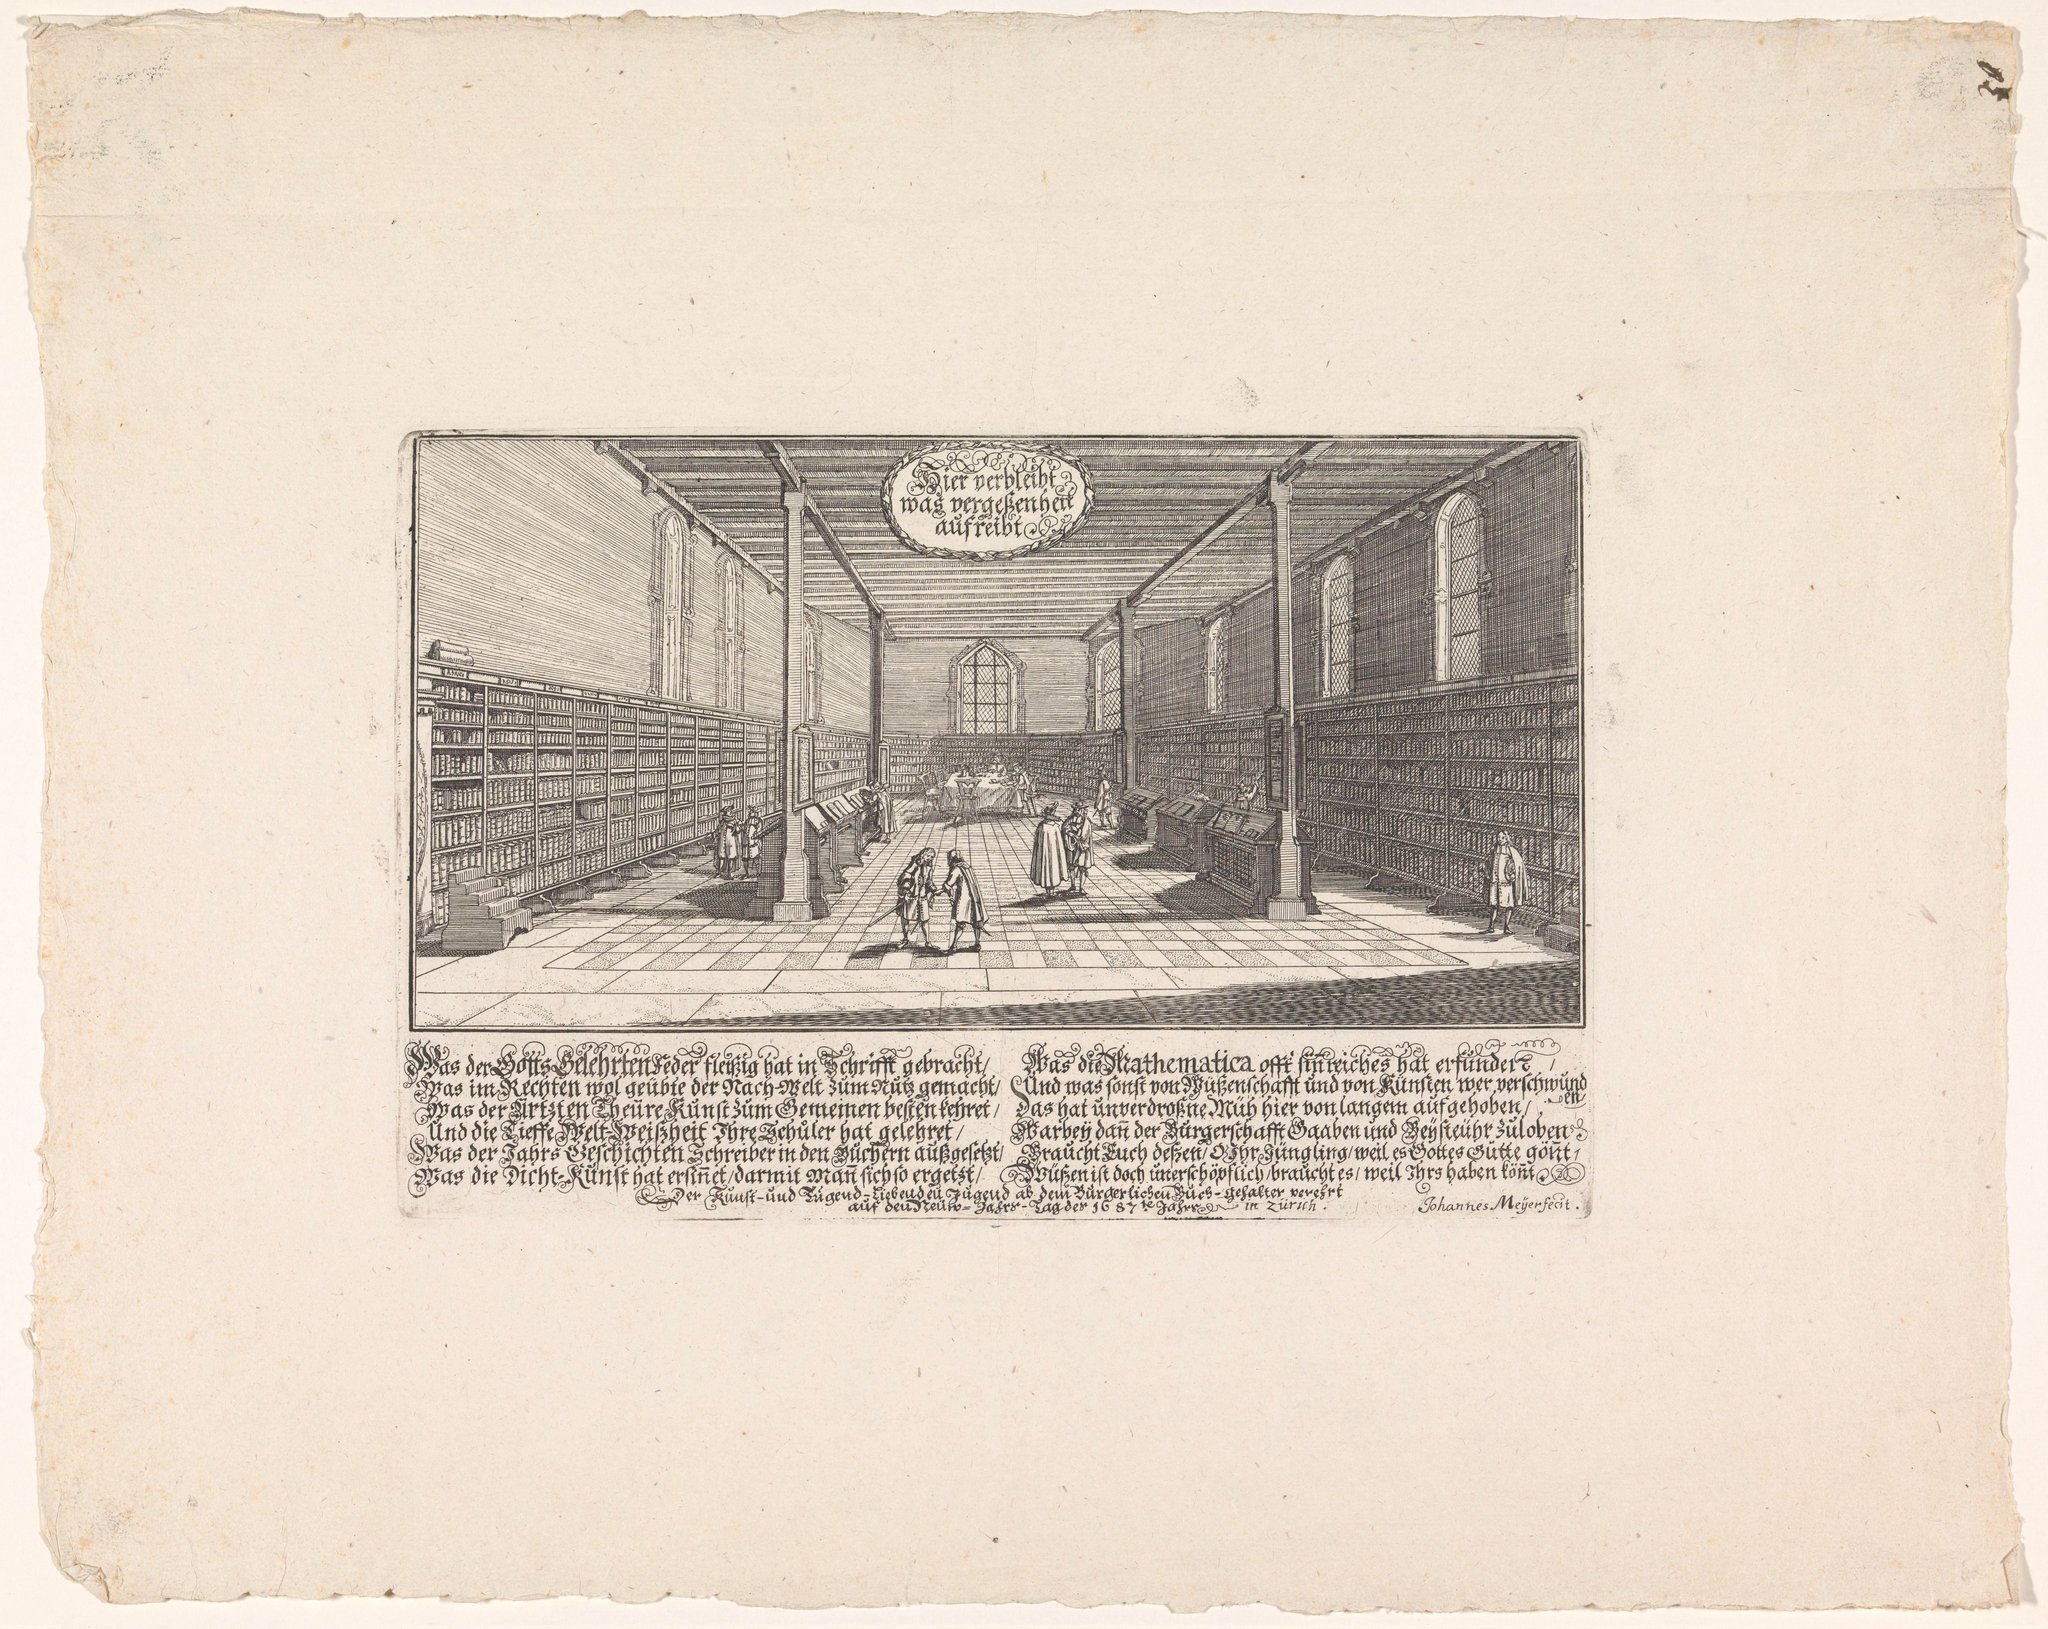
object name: print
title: Hier verbleibt was vergessenheit aufreibt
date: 1687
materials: paper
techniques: etching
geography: zurich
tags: public library, lectern ~ reading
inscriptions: collector's mark: Lugt 4779, number: ‘30’, watermark, collector's mark: Lugt 2228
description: De kerk is opgedeeld in twee verdiepingen; deze prent toont de onderste verdieping die wordt gebruikt als bibliotheek. De wanden zijn bedekt met boekenkasten en in het midden staan zes lessenaars. Met twaalfregelig onderschrift in het Duits.